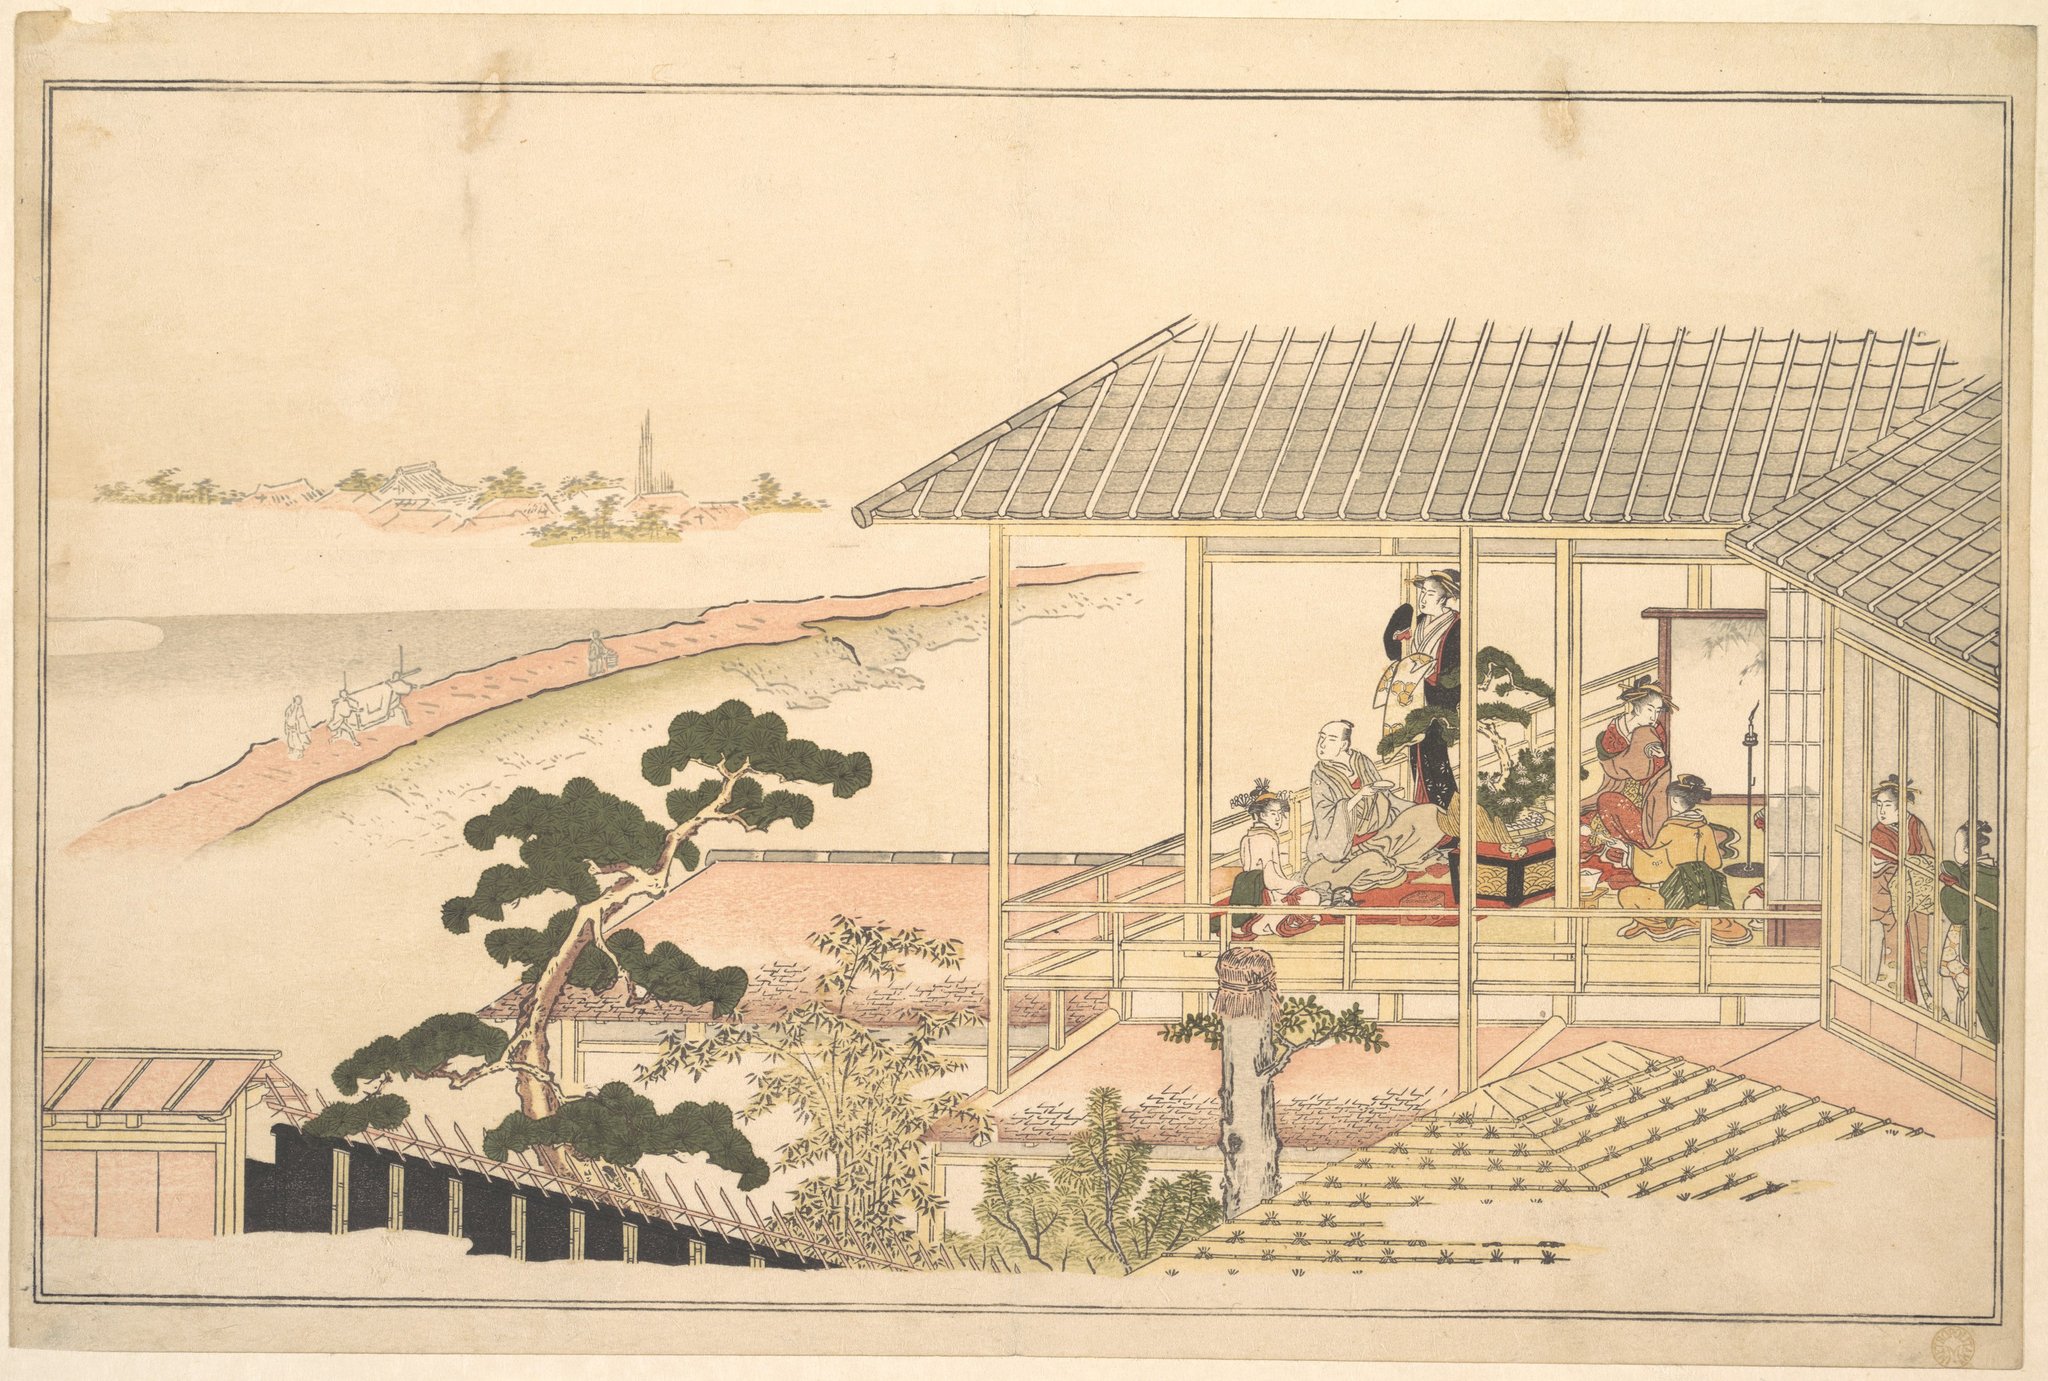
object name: print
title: A Party of Merrymakers in a House in the Yoshiwara on a Moonlight Night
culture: japanese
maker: kitagawa utamaro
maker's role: artist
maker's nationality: japanese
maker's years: 1754-1806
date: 1789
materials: ink, paper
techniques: woodblock print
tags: houses,men,women,party,trees